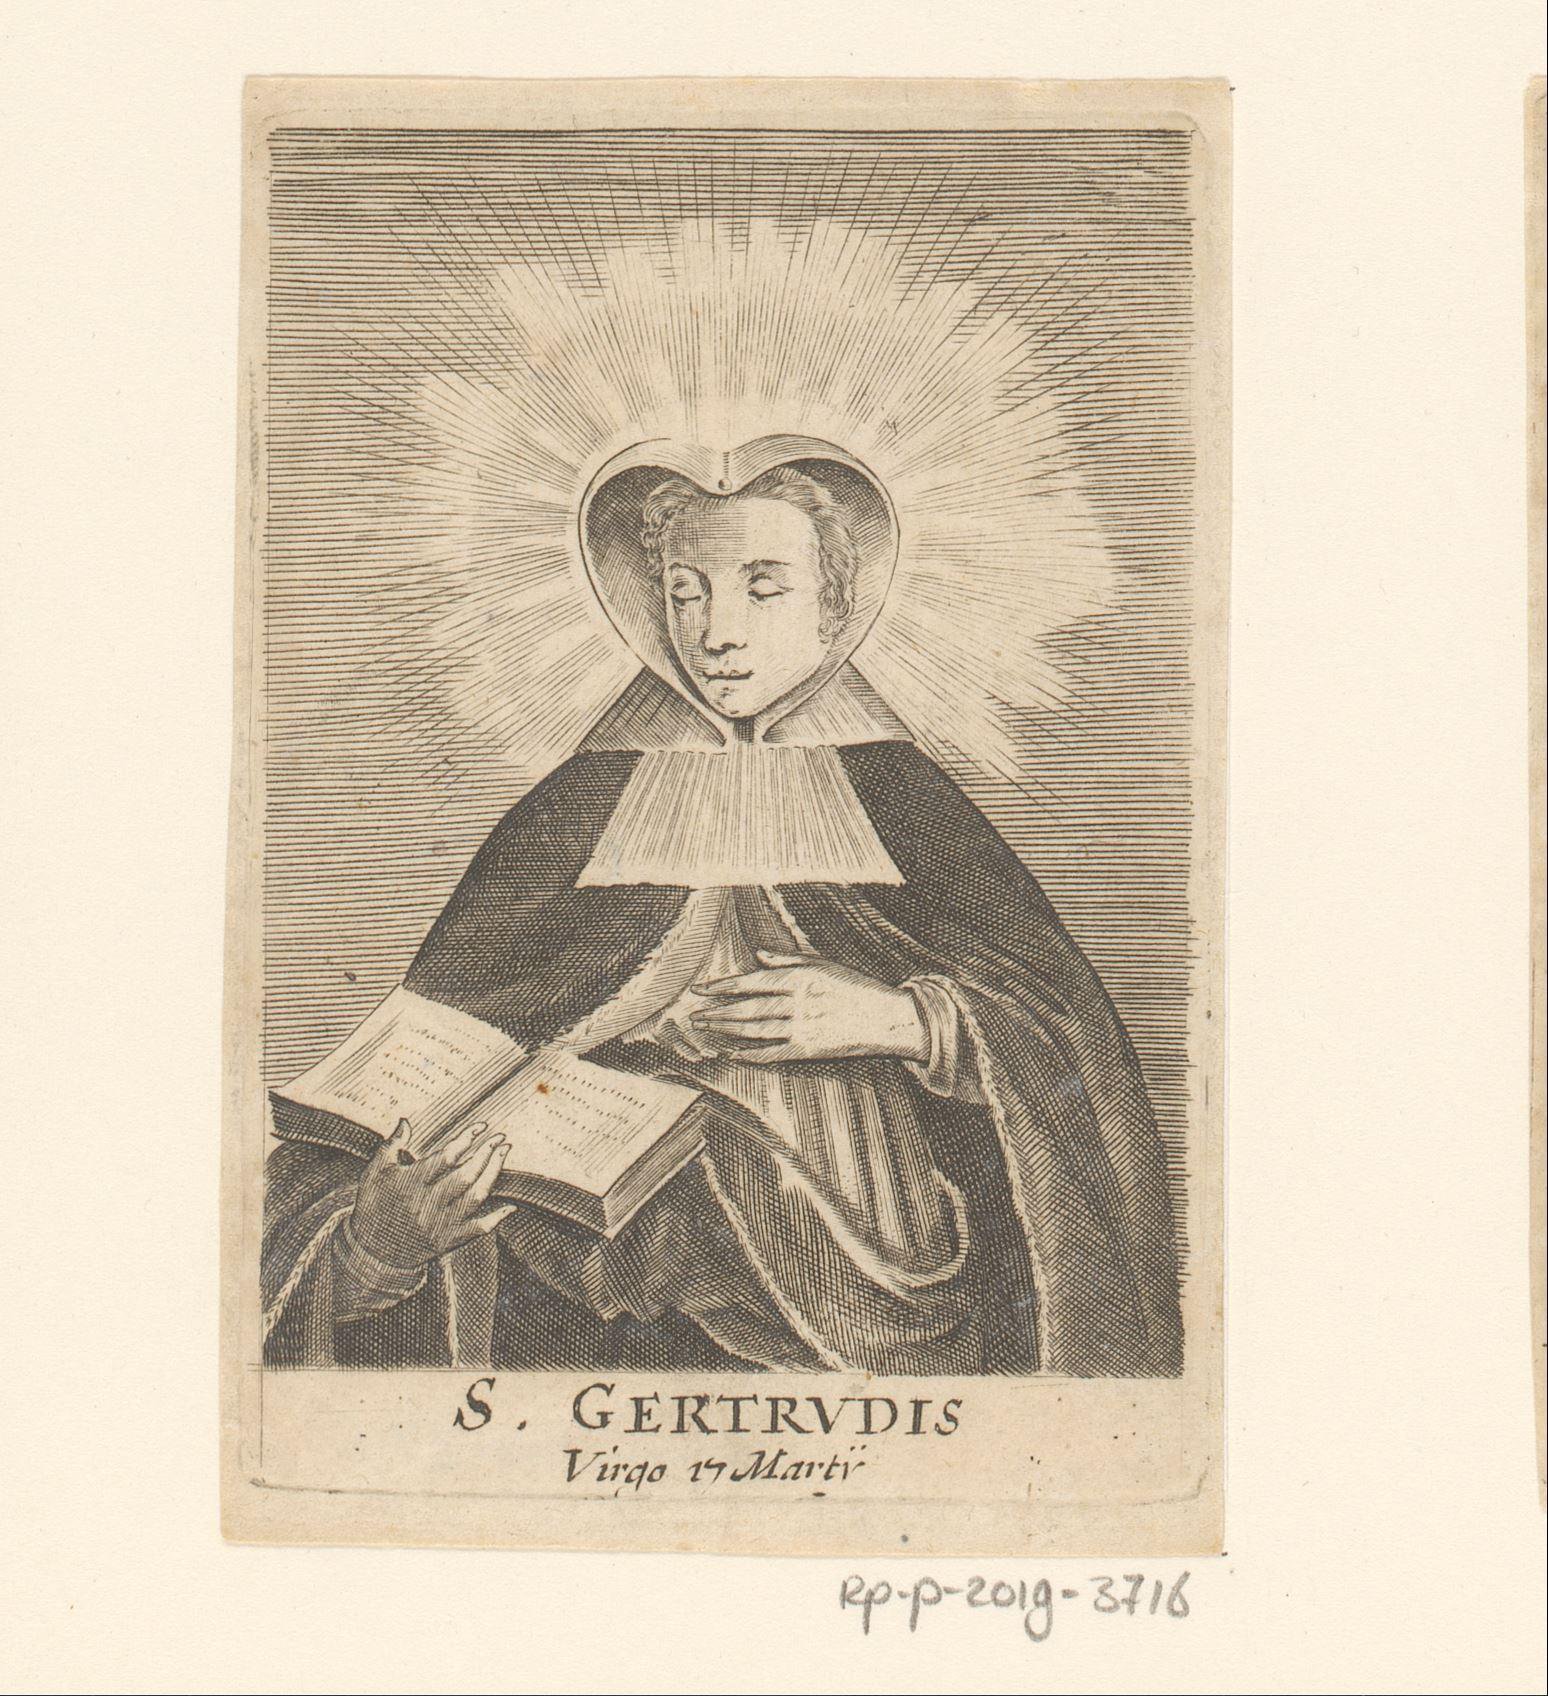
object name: print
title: Vrouwelijke heiligen en hun naamdagen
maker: Anonymous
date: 1600-1699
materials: paper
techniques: engraving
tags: female saints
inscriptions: collector's mark: Lugt 2228